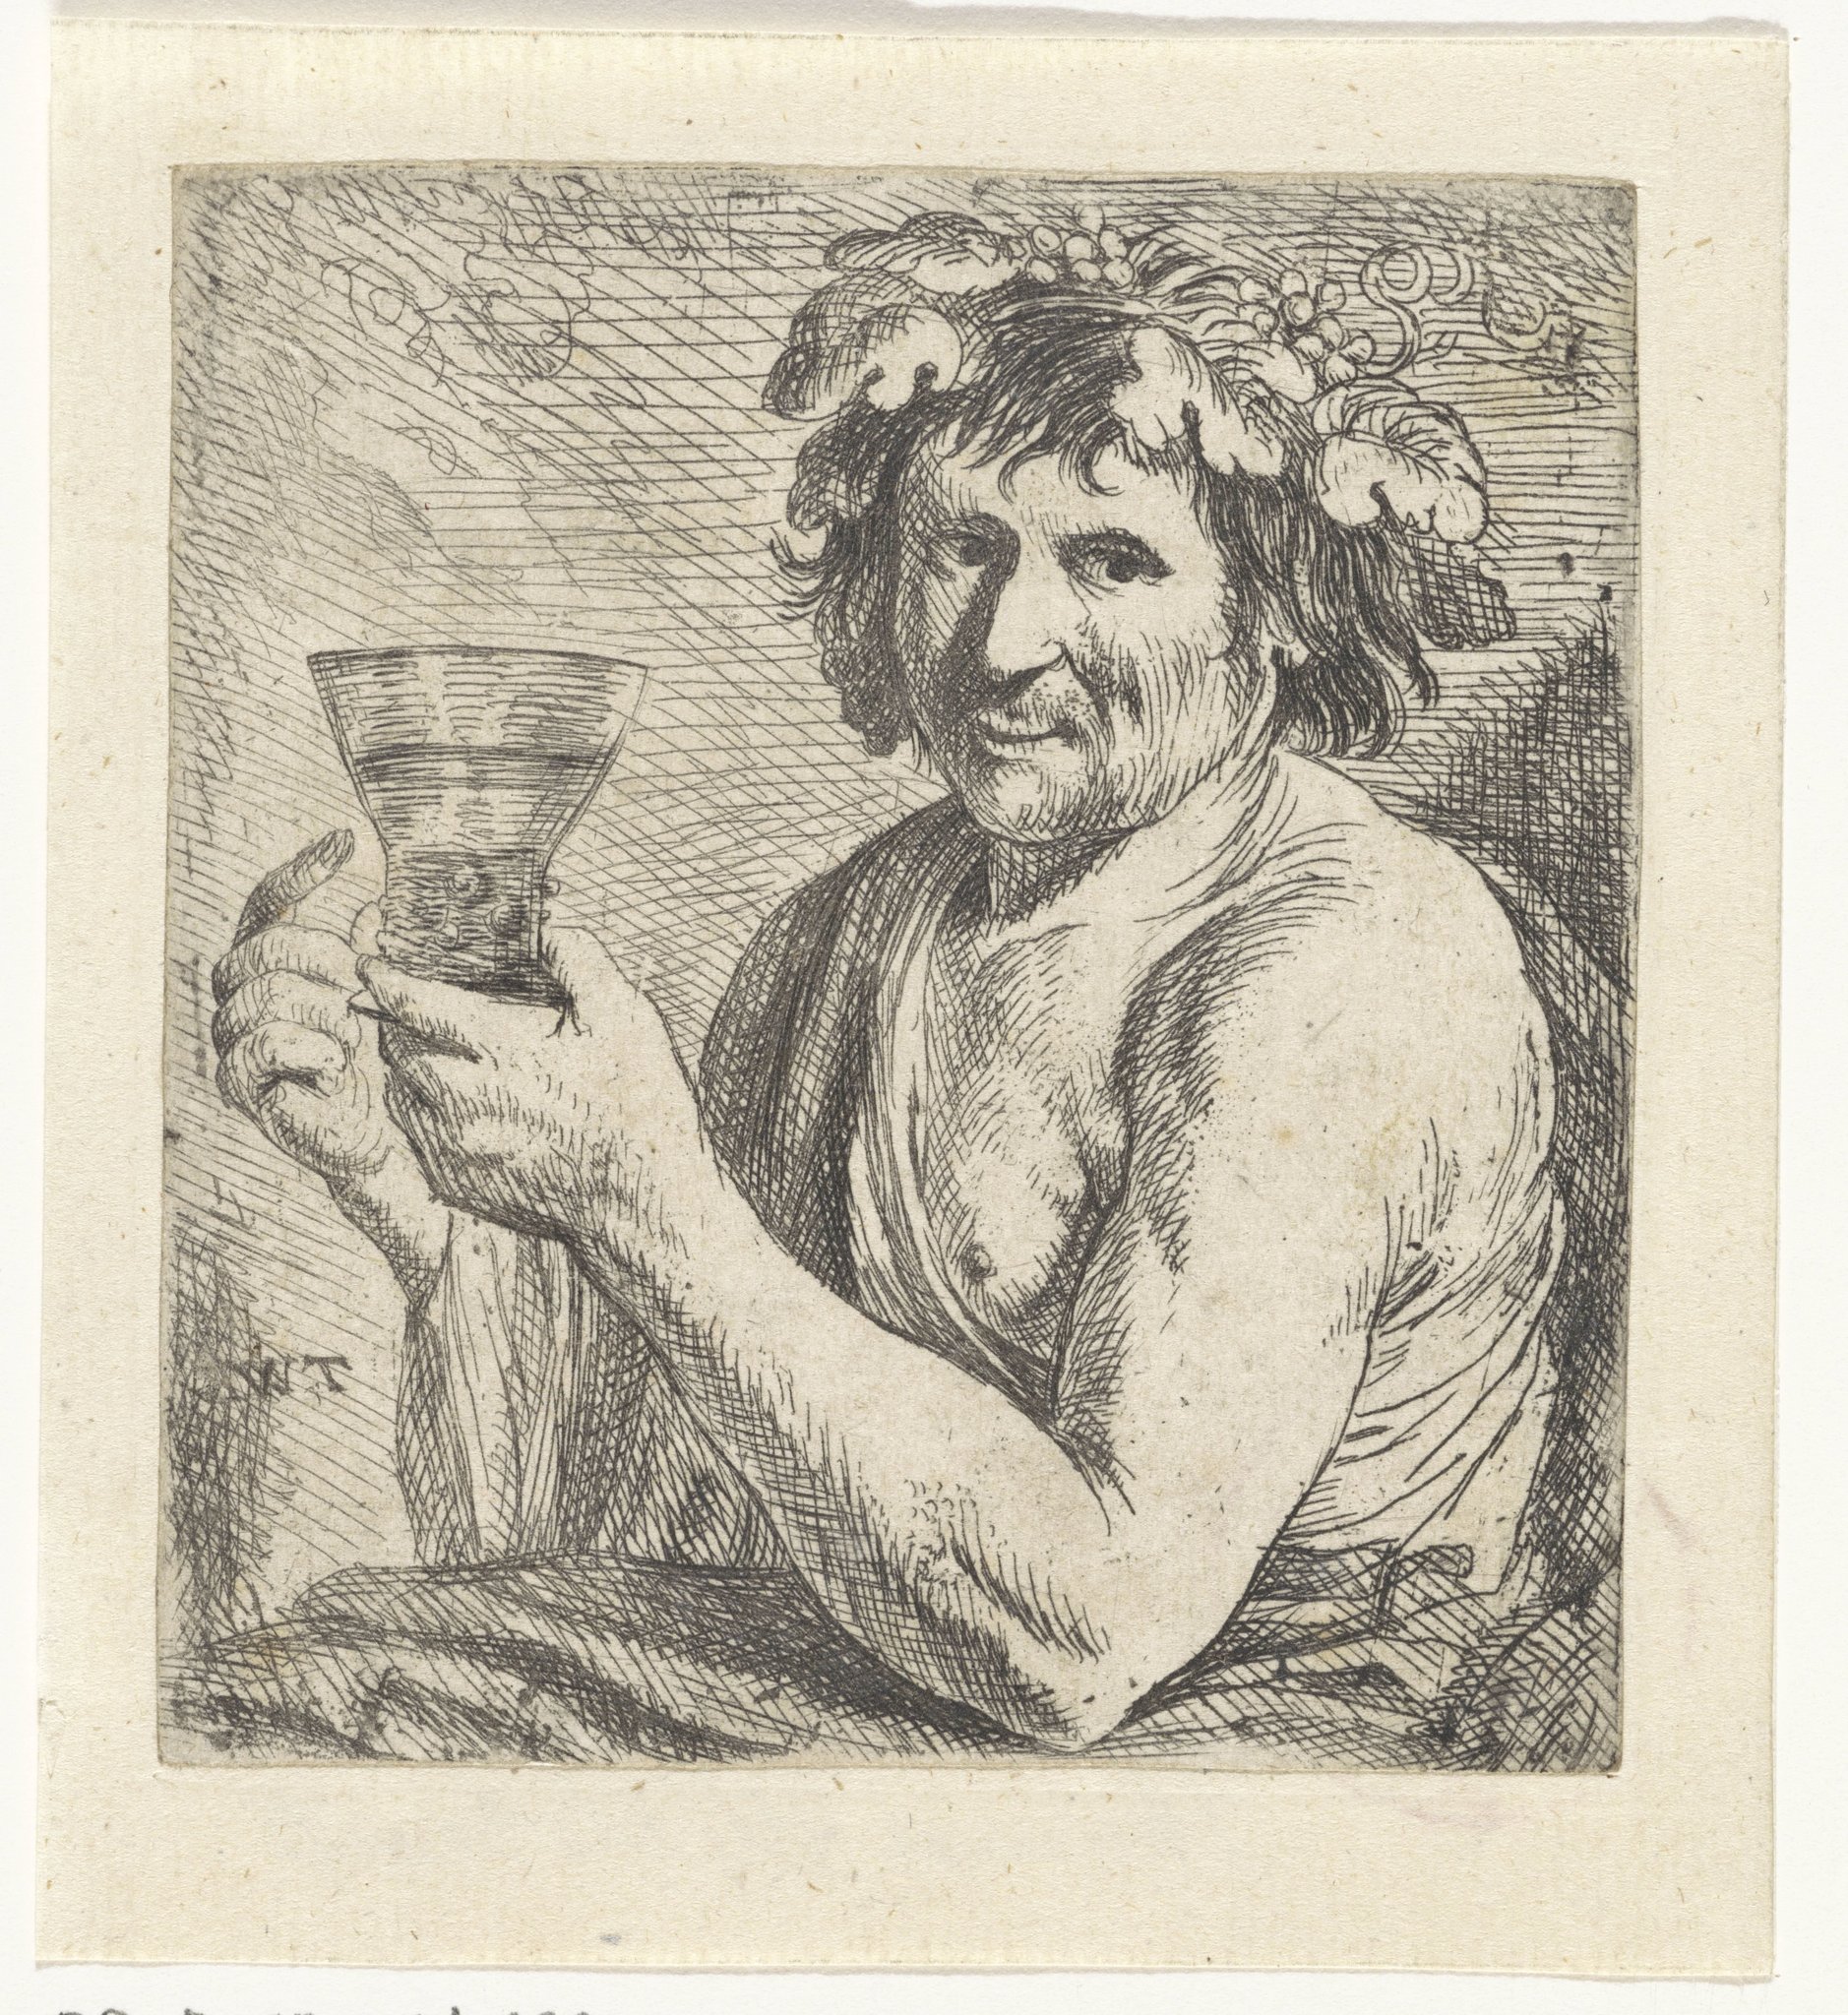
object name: print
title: Bacchant met roemer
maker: thomas willeboirts bosschaert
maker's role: draughtsman, painter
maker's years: 1613-1654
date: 1628-1654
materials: paper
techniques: etching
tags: (story of) bacchus (dionysus), liber, glass, rummer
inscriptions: collector's mark: Lugt 240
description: Bacchus wijst naar een roemer in zijn linkerhand.